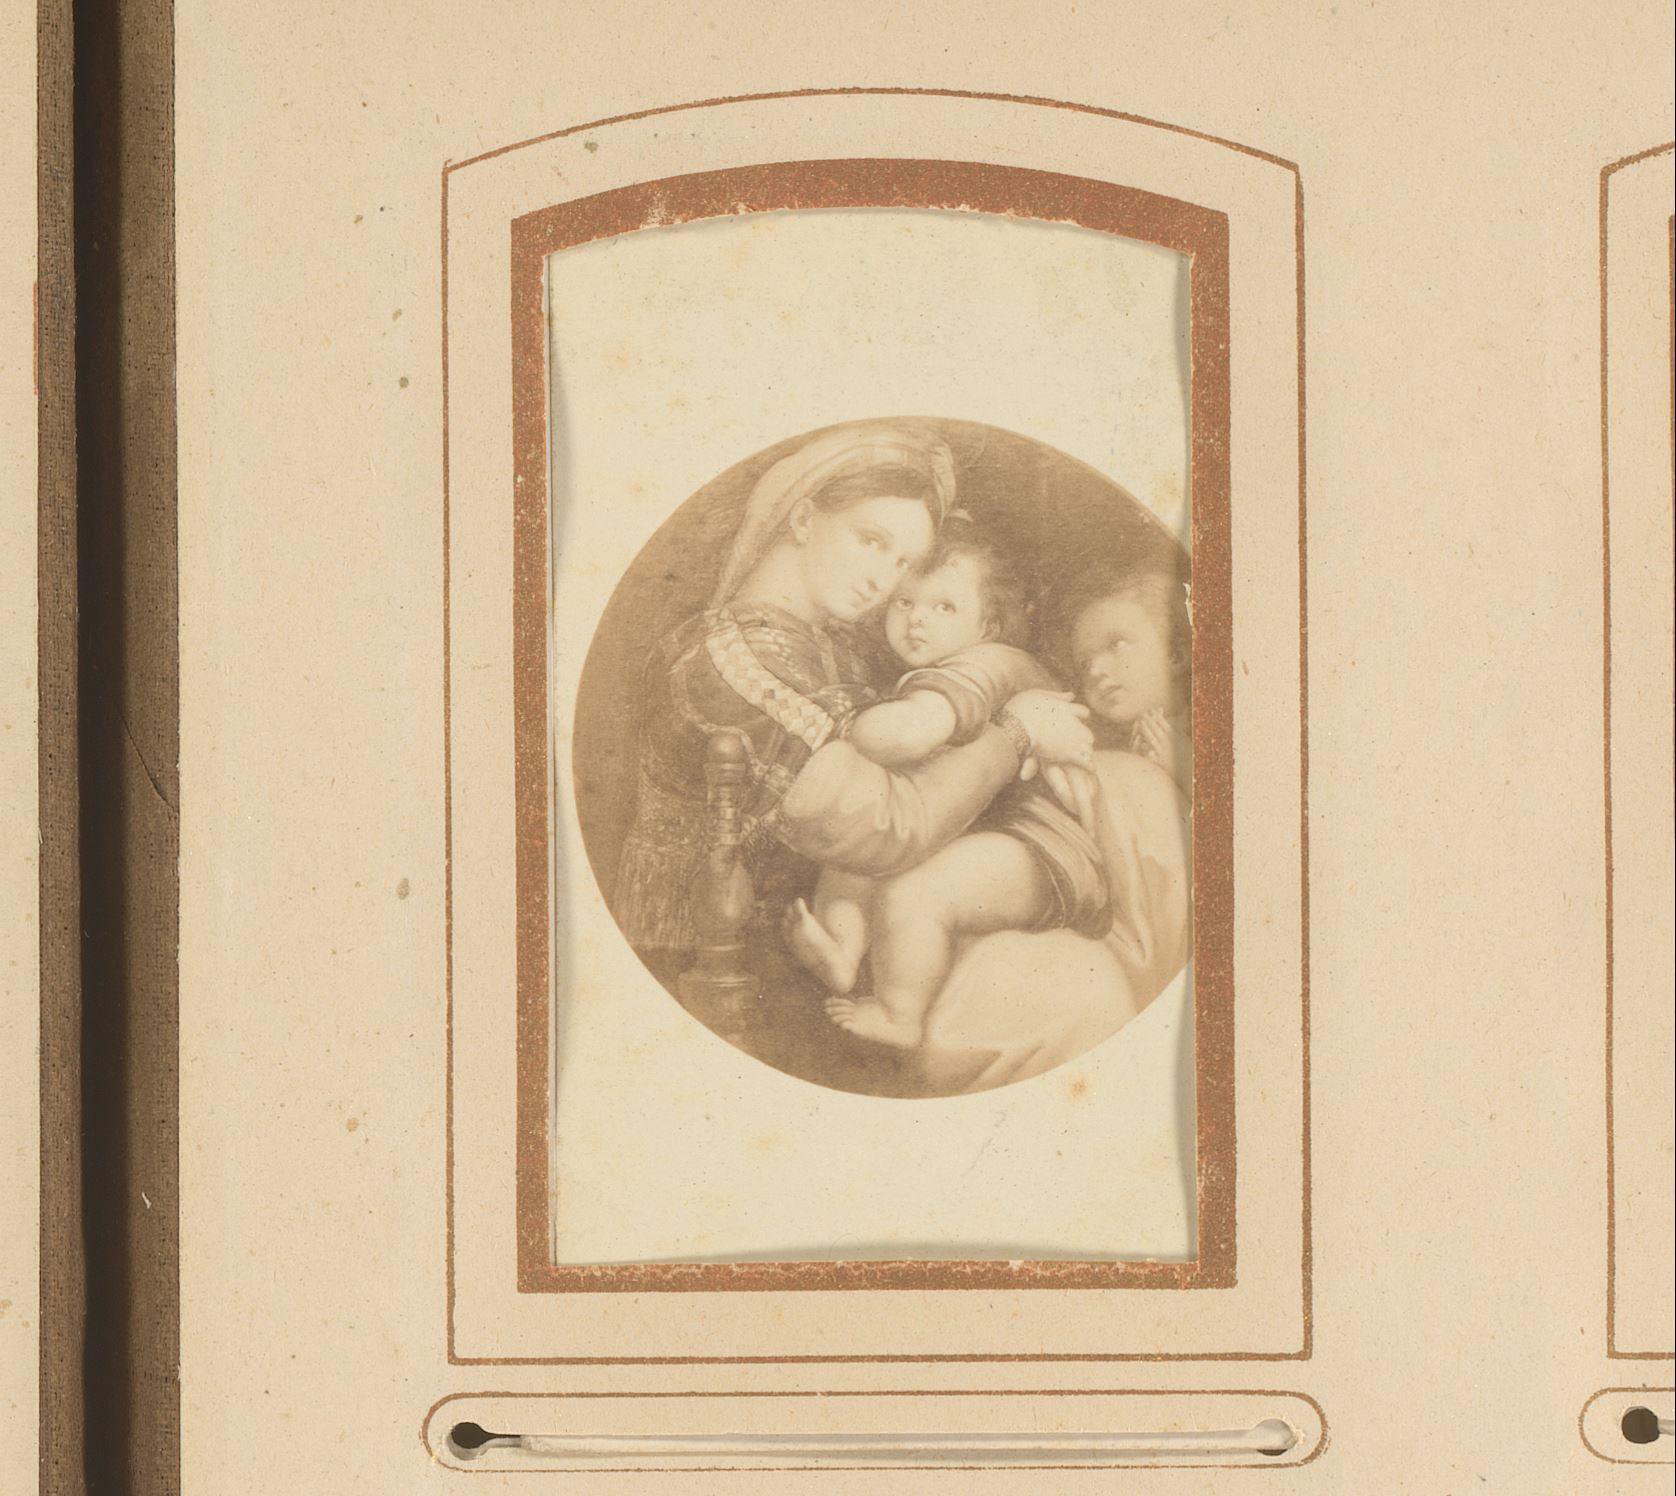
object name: carte de visite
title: Fotoreproductie van Madonna met stoel door Rafaël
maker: rafaël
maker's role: painter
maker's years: 1483-1520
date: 1850-1900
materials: cardboard, photographic support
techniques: albumen print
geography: florence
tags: mary and the christ-child with john the baptist (as child)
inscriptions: inscription: ‘FRATELLI ALINARI/ FIRENZE/ Piazza S. Gaetano’, annotation: ‘164/ Madonna della Seg-/ giola Rafaella/ Florenz’